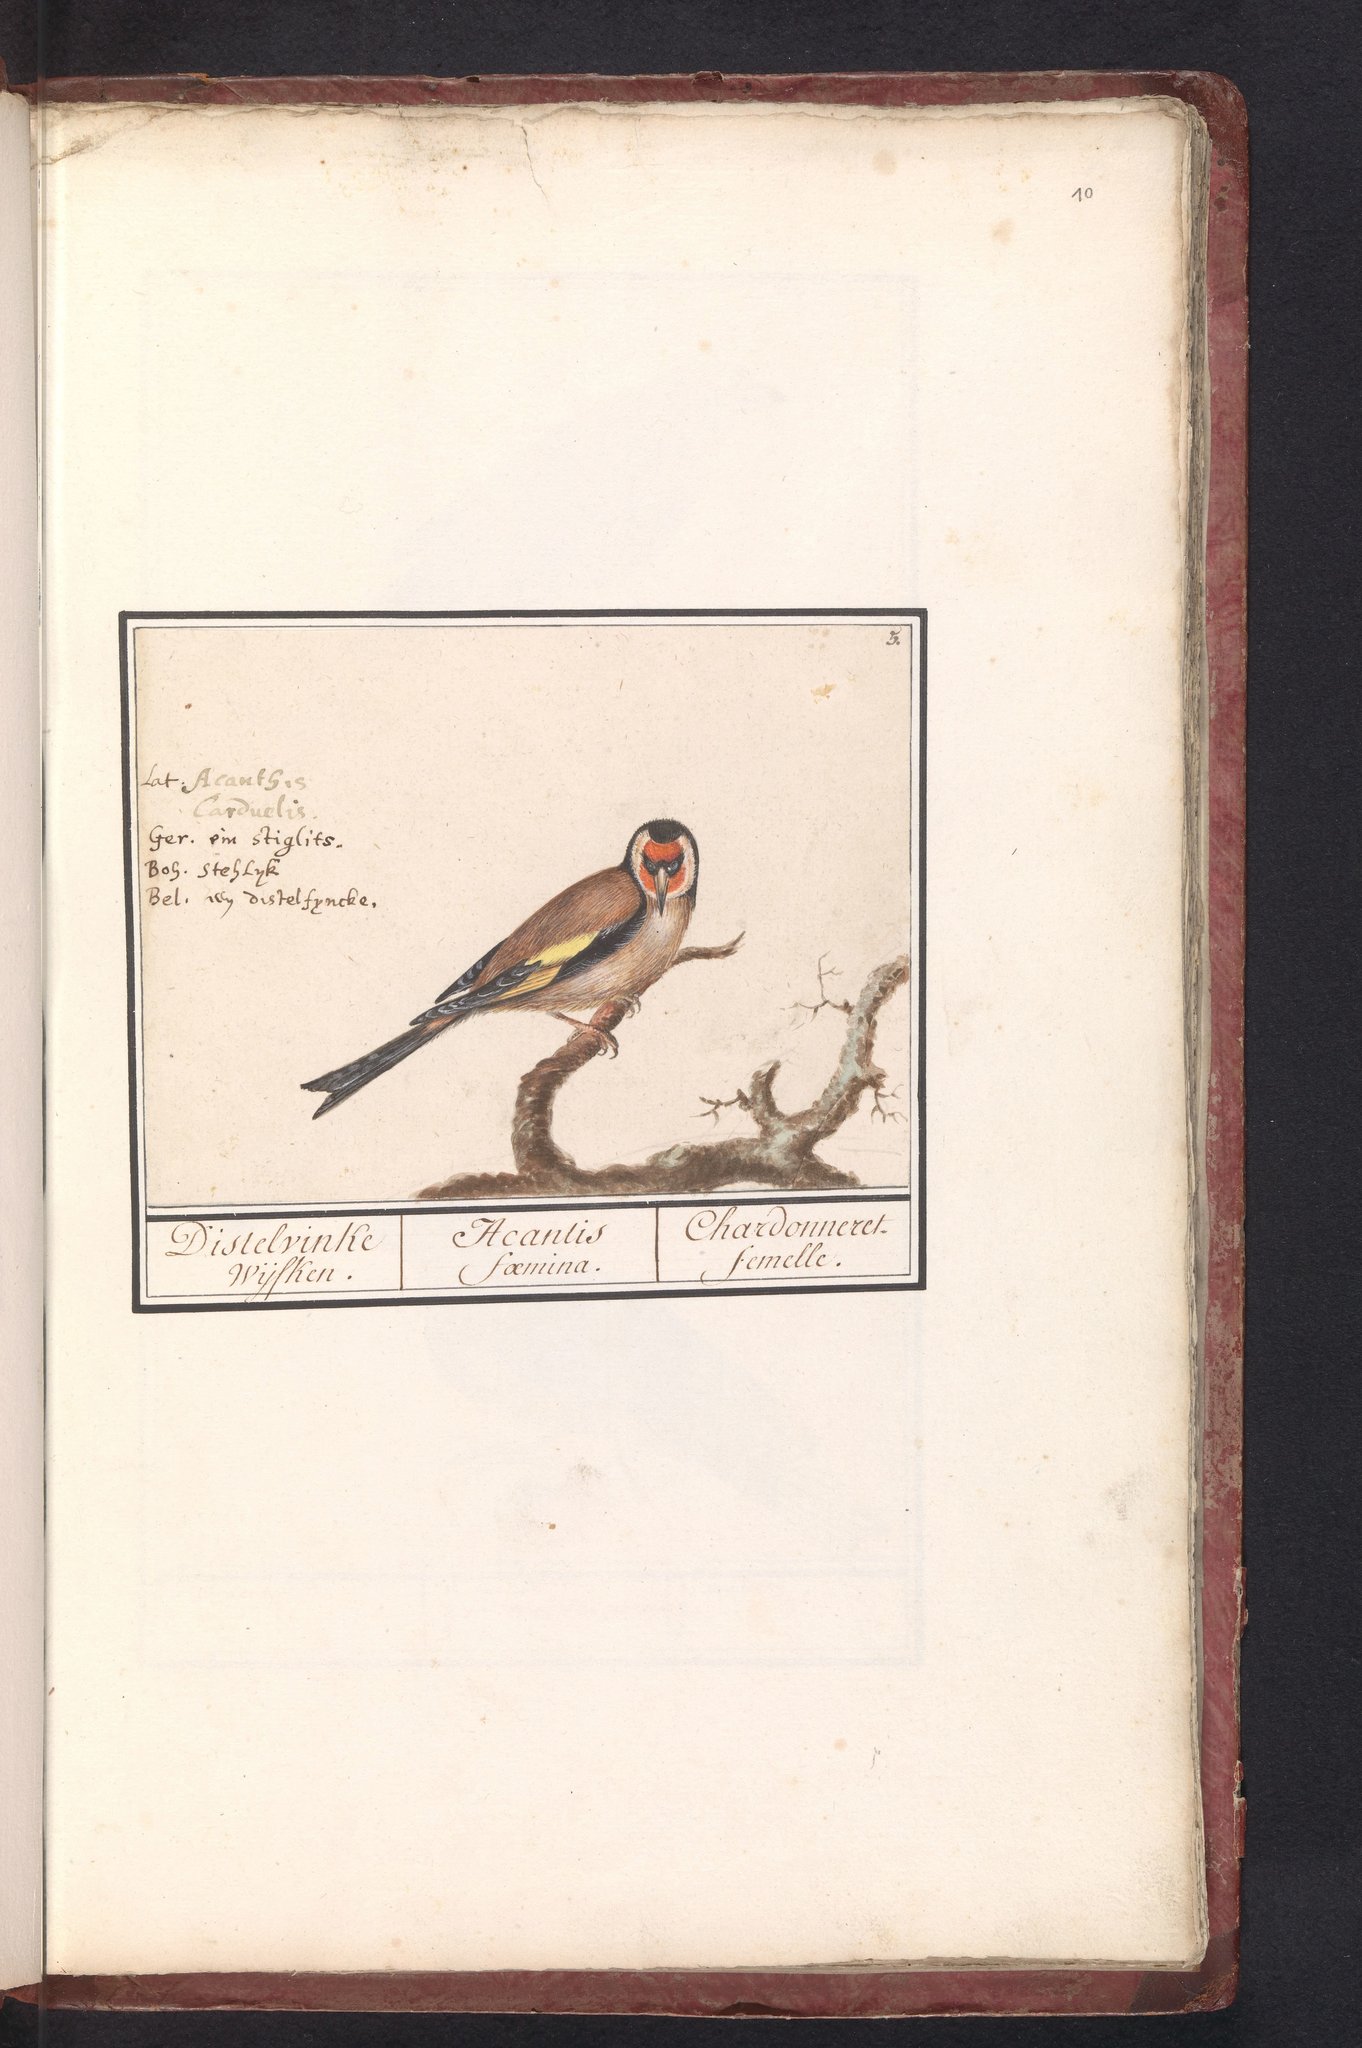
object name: drawing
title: Putter of distelvink (Carduelis carduelis)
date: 1596-1610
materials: paint, ink, paper, pencil, watercolor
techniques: brush, pen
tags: song-birds: goldfinch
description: Putter of distelvink (vrouwtje). Genummerd rechtsboven: 5. Linksboven de naam in vier talen. Onderdeel van het tweede album met tekeningen van vogels. Vierde van twaalf albums met tekeningen van dieren, vogels en planten bekend rond 1600, gemaakt in opdracht van keizer Rudolf II. Met toelichting in Nederlands, Latijn en Frans.